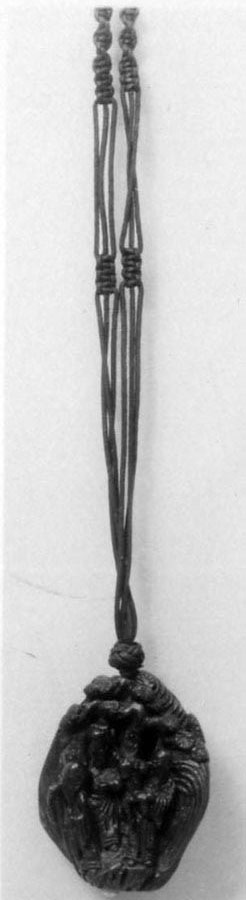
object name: pendant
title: Pendant with Daoist divinities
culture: chinese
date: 1801-1900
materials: stone